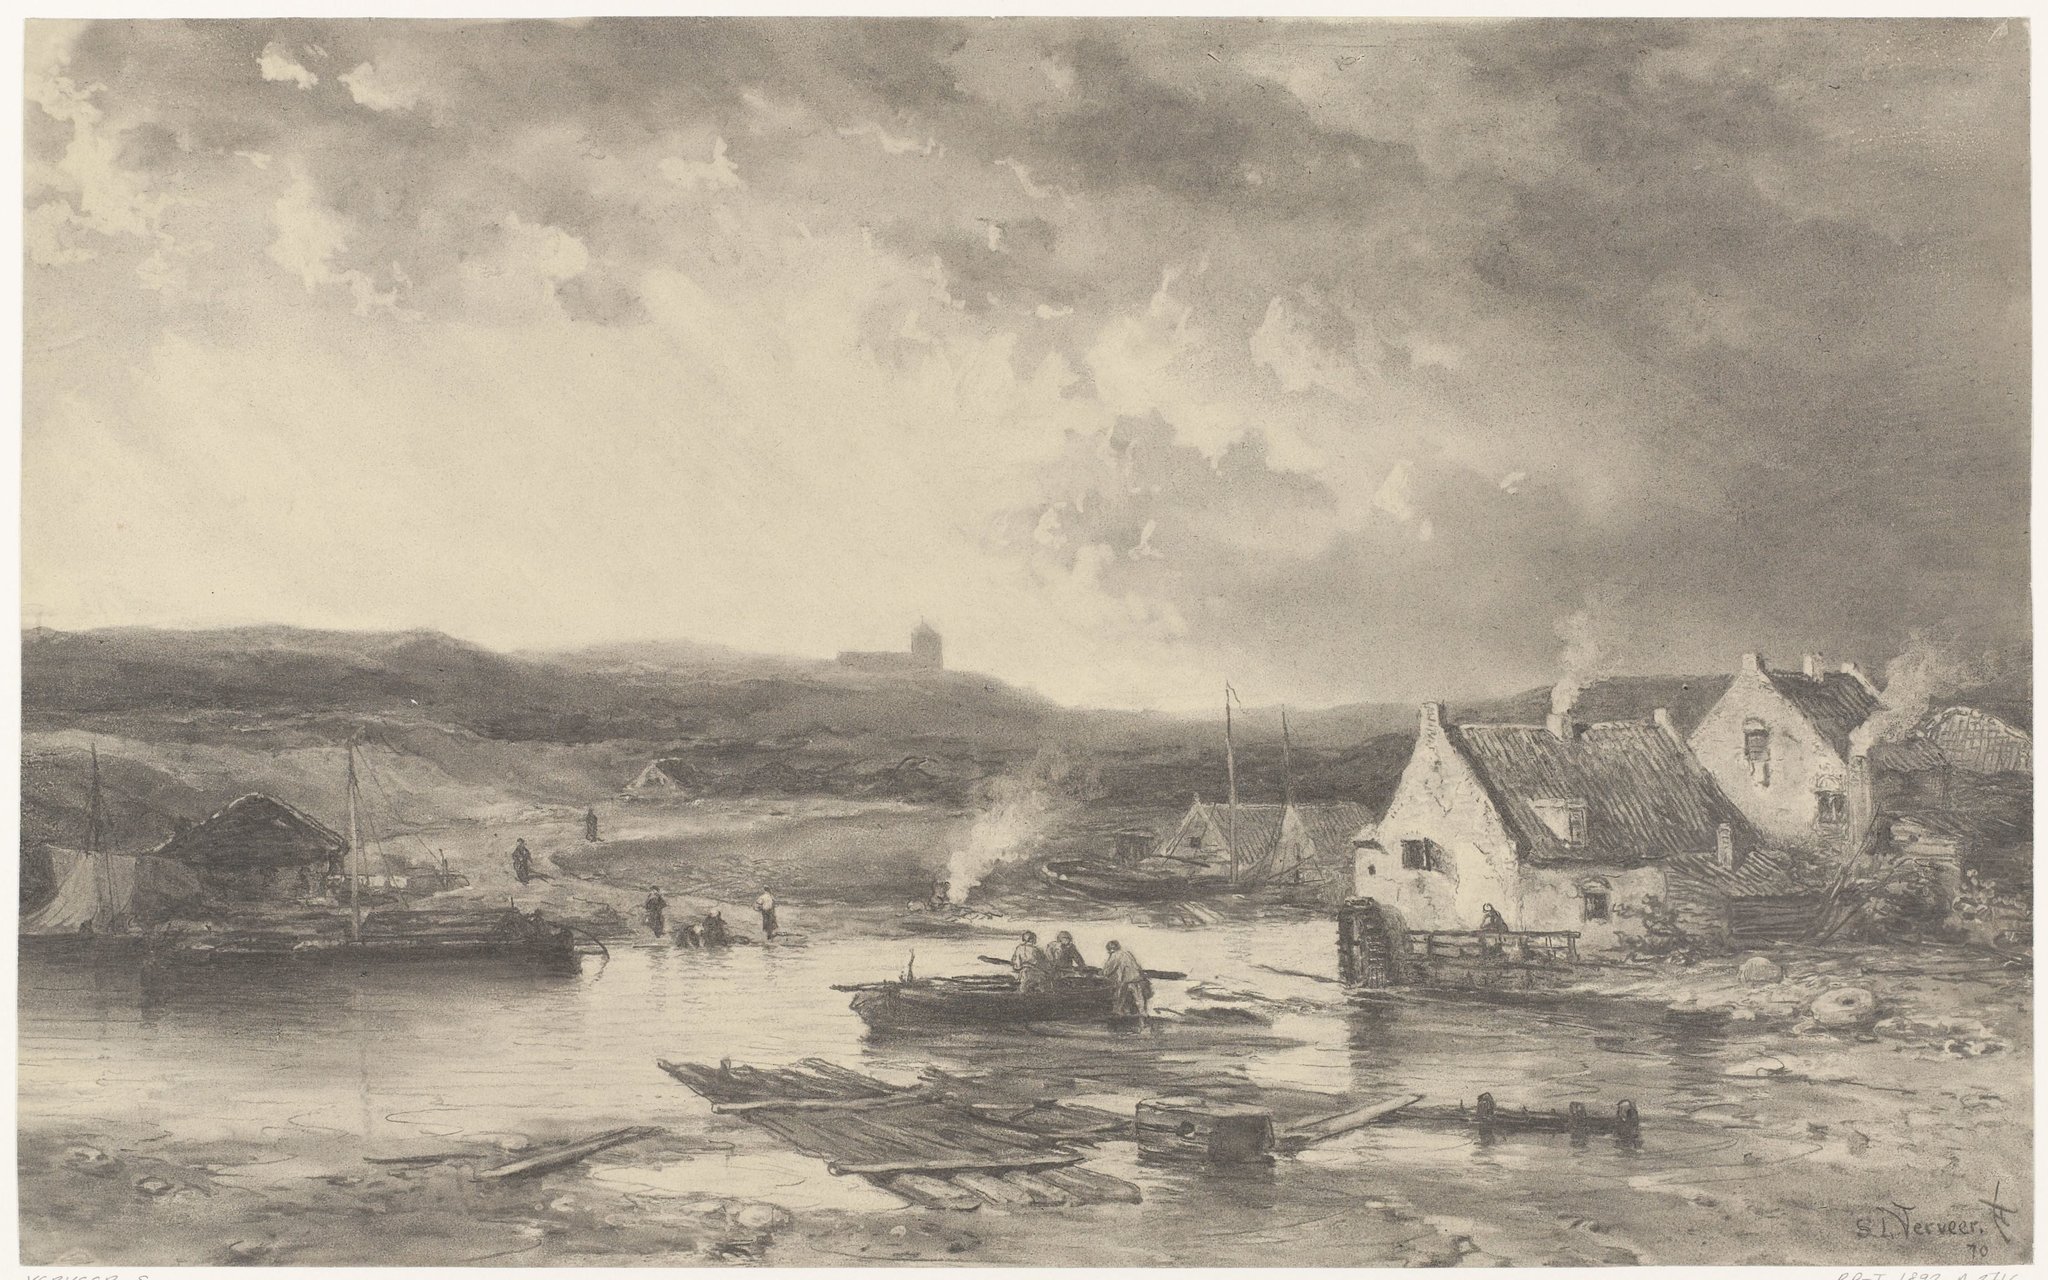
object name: drawing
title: Rivierlandschap met enige huizen en een watermolen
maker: salomon leonardus verveer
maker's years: 1813-1876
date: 1870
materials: chalk, paper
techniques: brush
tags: river, watermill in landscape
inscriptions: date: ‘70’